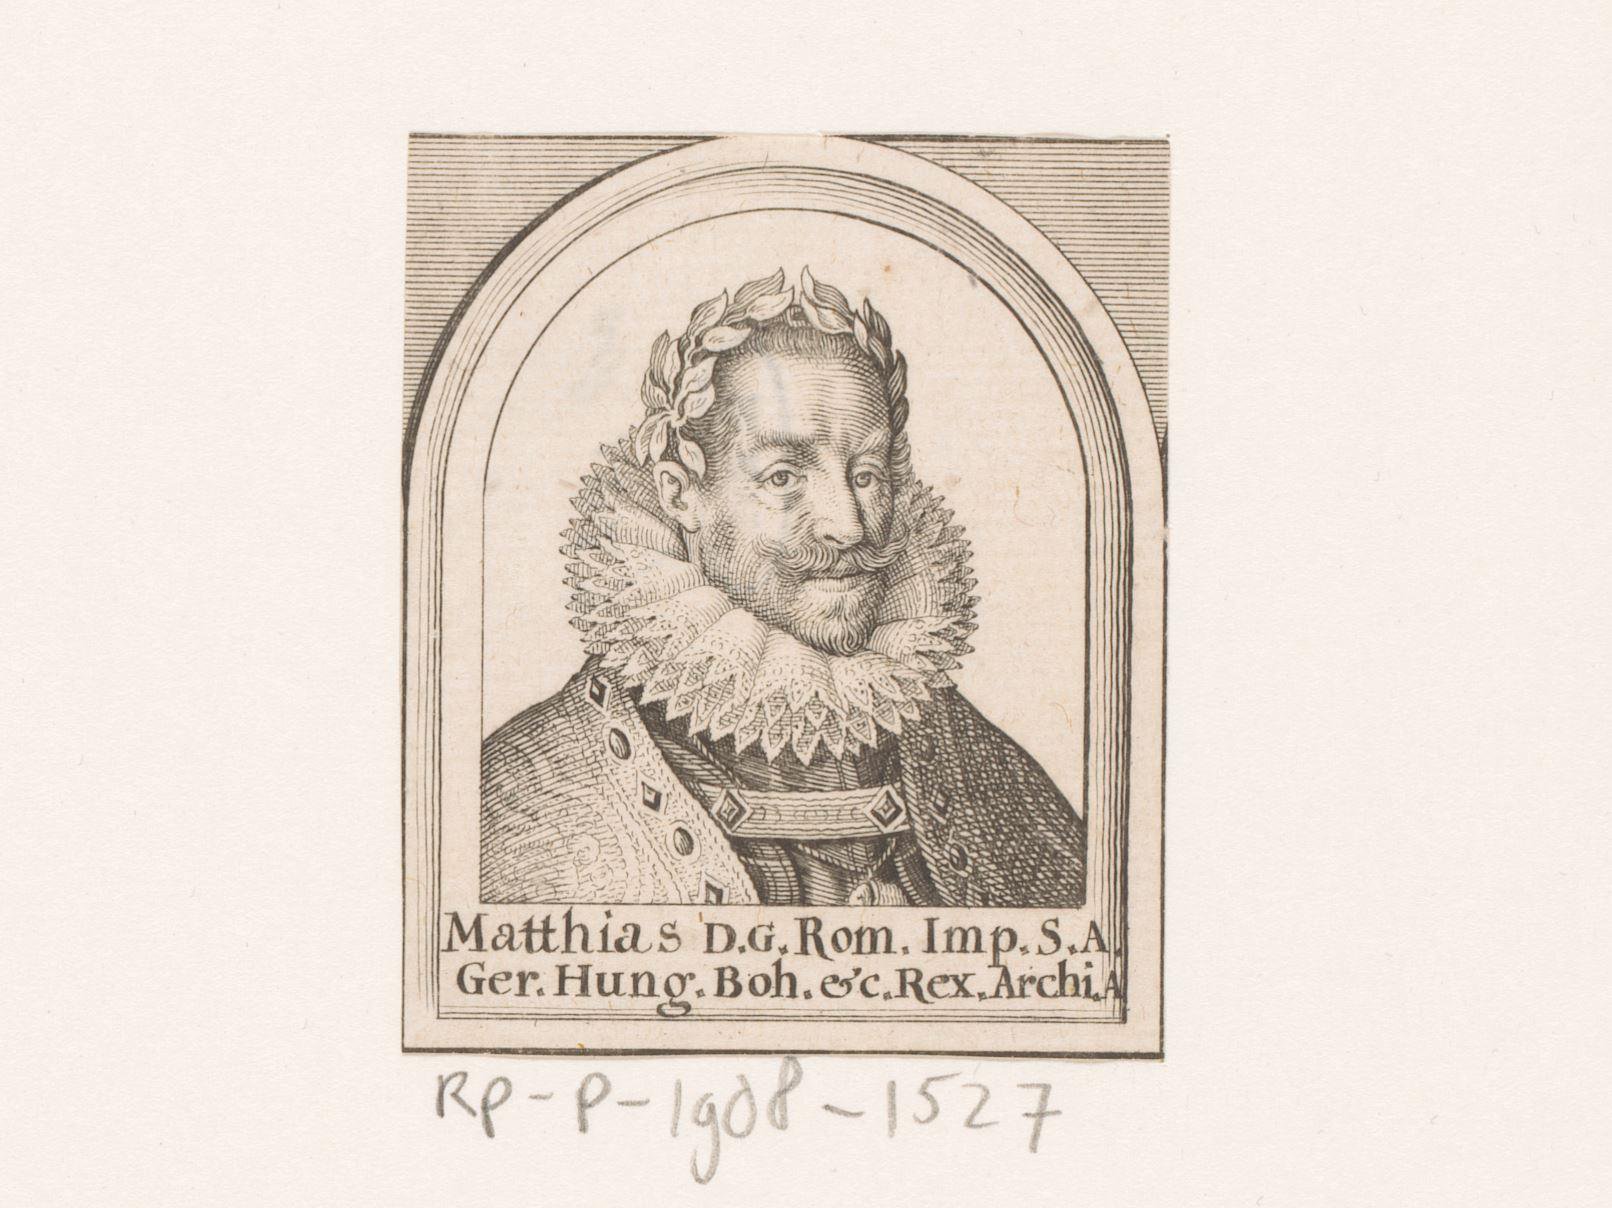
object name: print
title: Portret van keizer Matthias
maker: matthäus merian (i)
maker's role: print maker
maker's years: 1593-1650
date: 1603-1650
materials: paper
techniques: engraving, etching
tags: matthias van oostenrijk (rooms-duits keizer), garland, wreath, historical persons